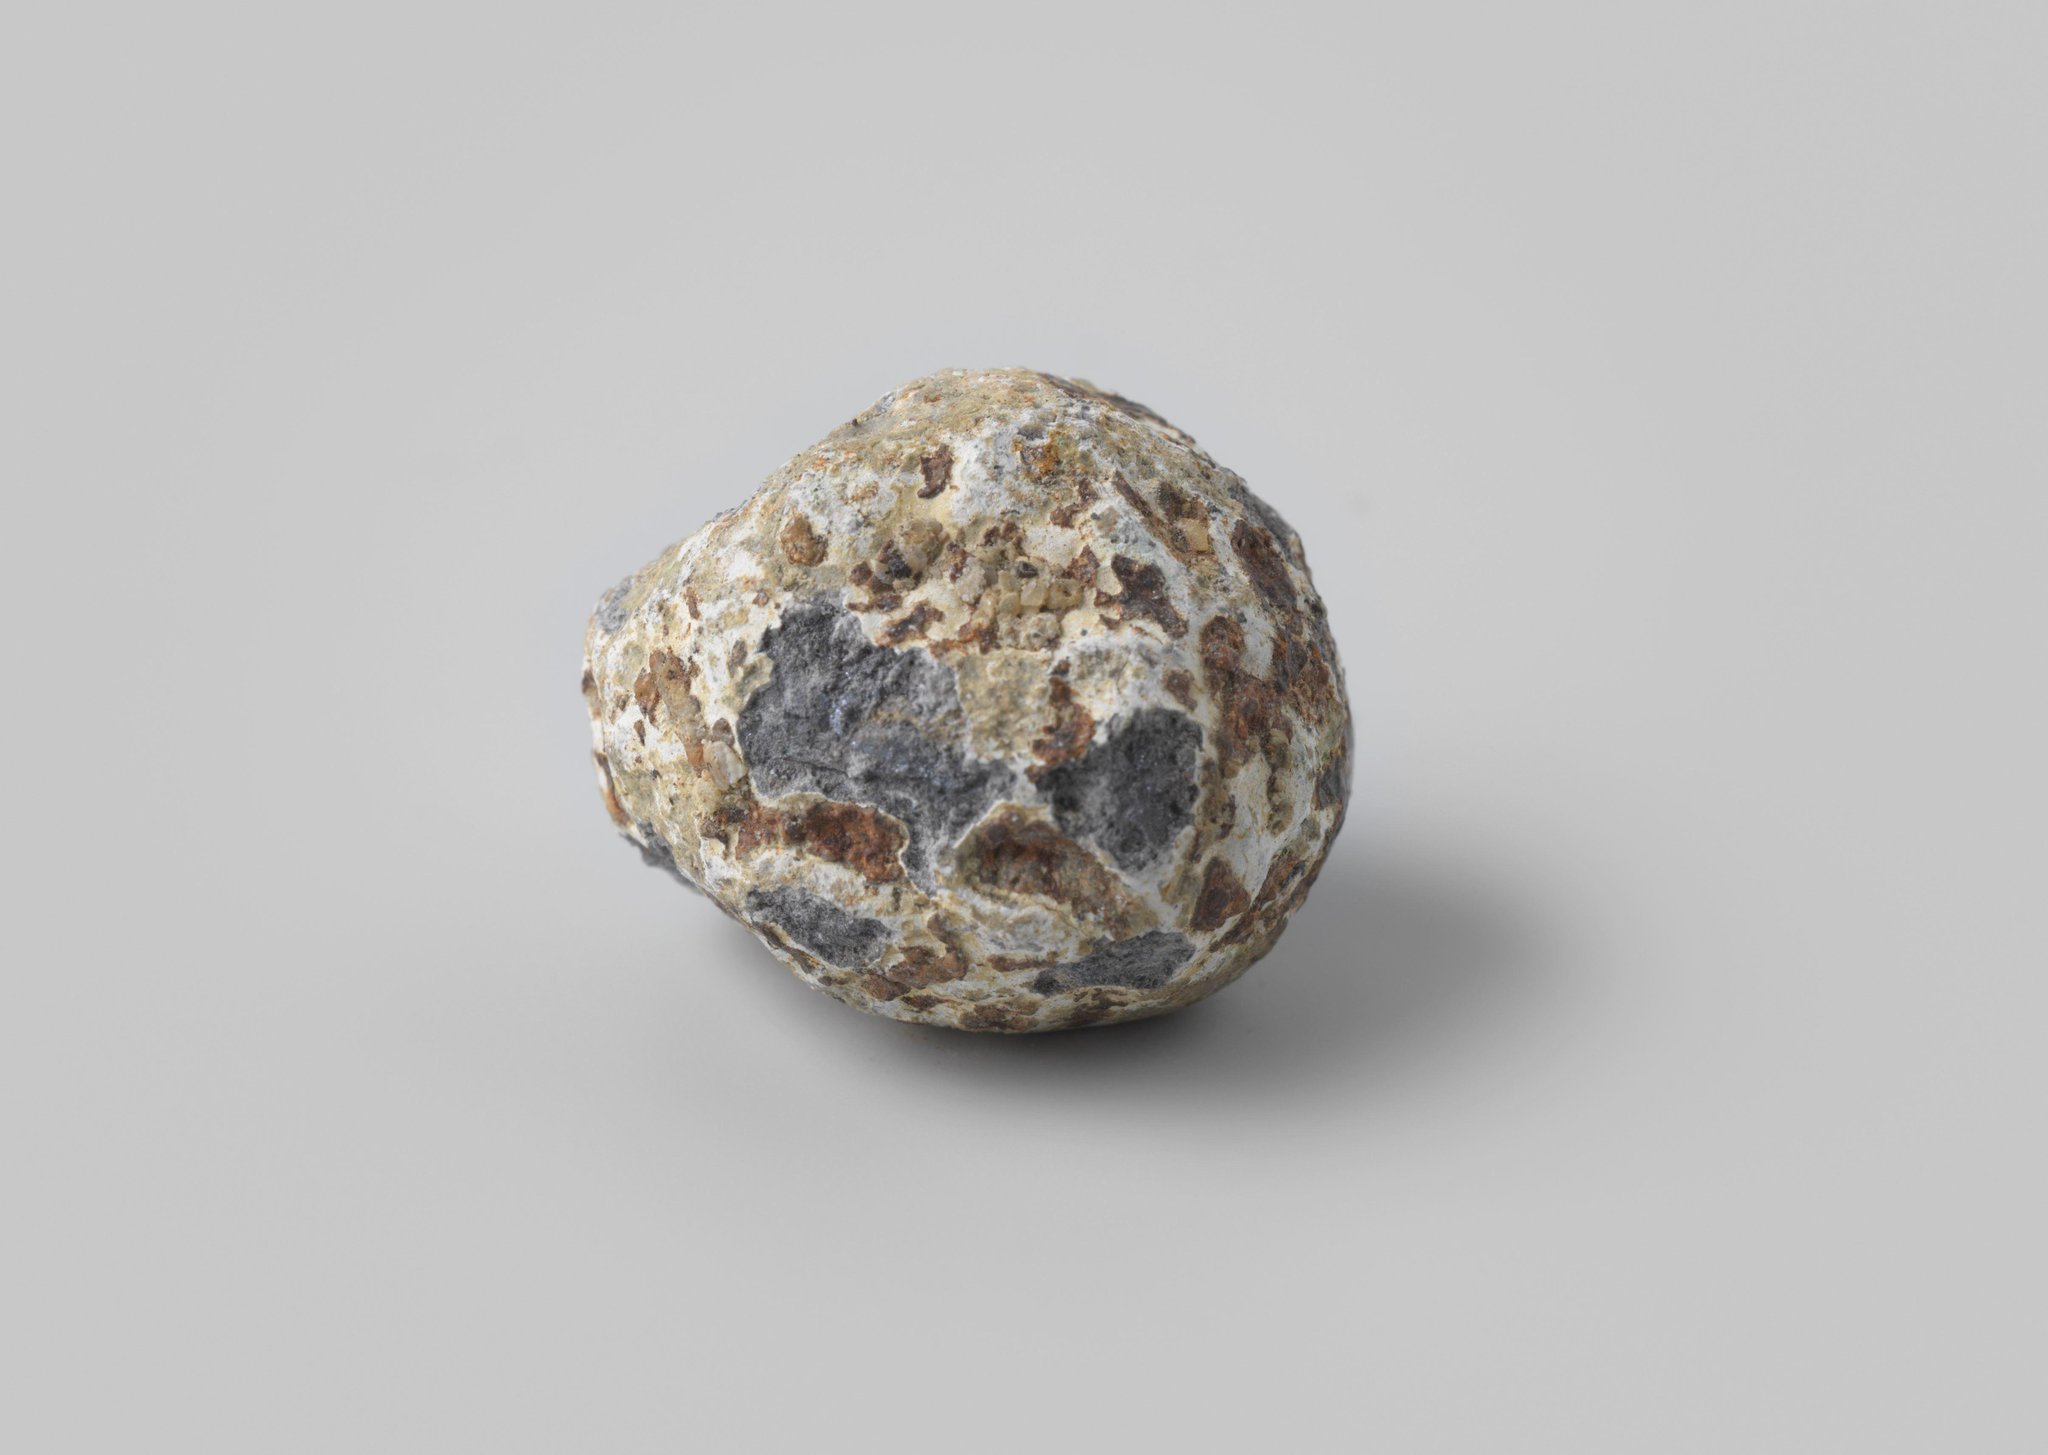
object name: musketkogel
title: Musketkogel uit het wrak van de Oost-Indiëvaarder Hollandia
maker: Anonymous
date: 1700-1743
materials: lead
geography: netherlands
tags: verenigde oostindische compagnie, hollandia (schip), annet